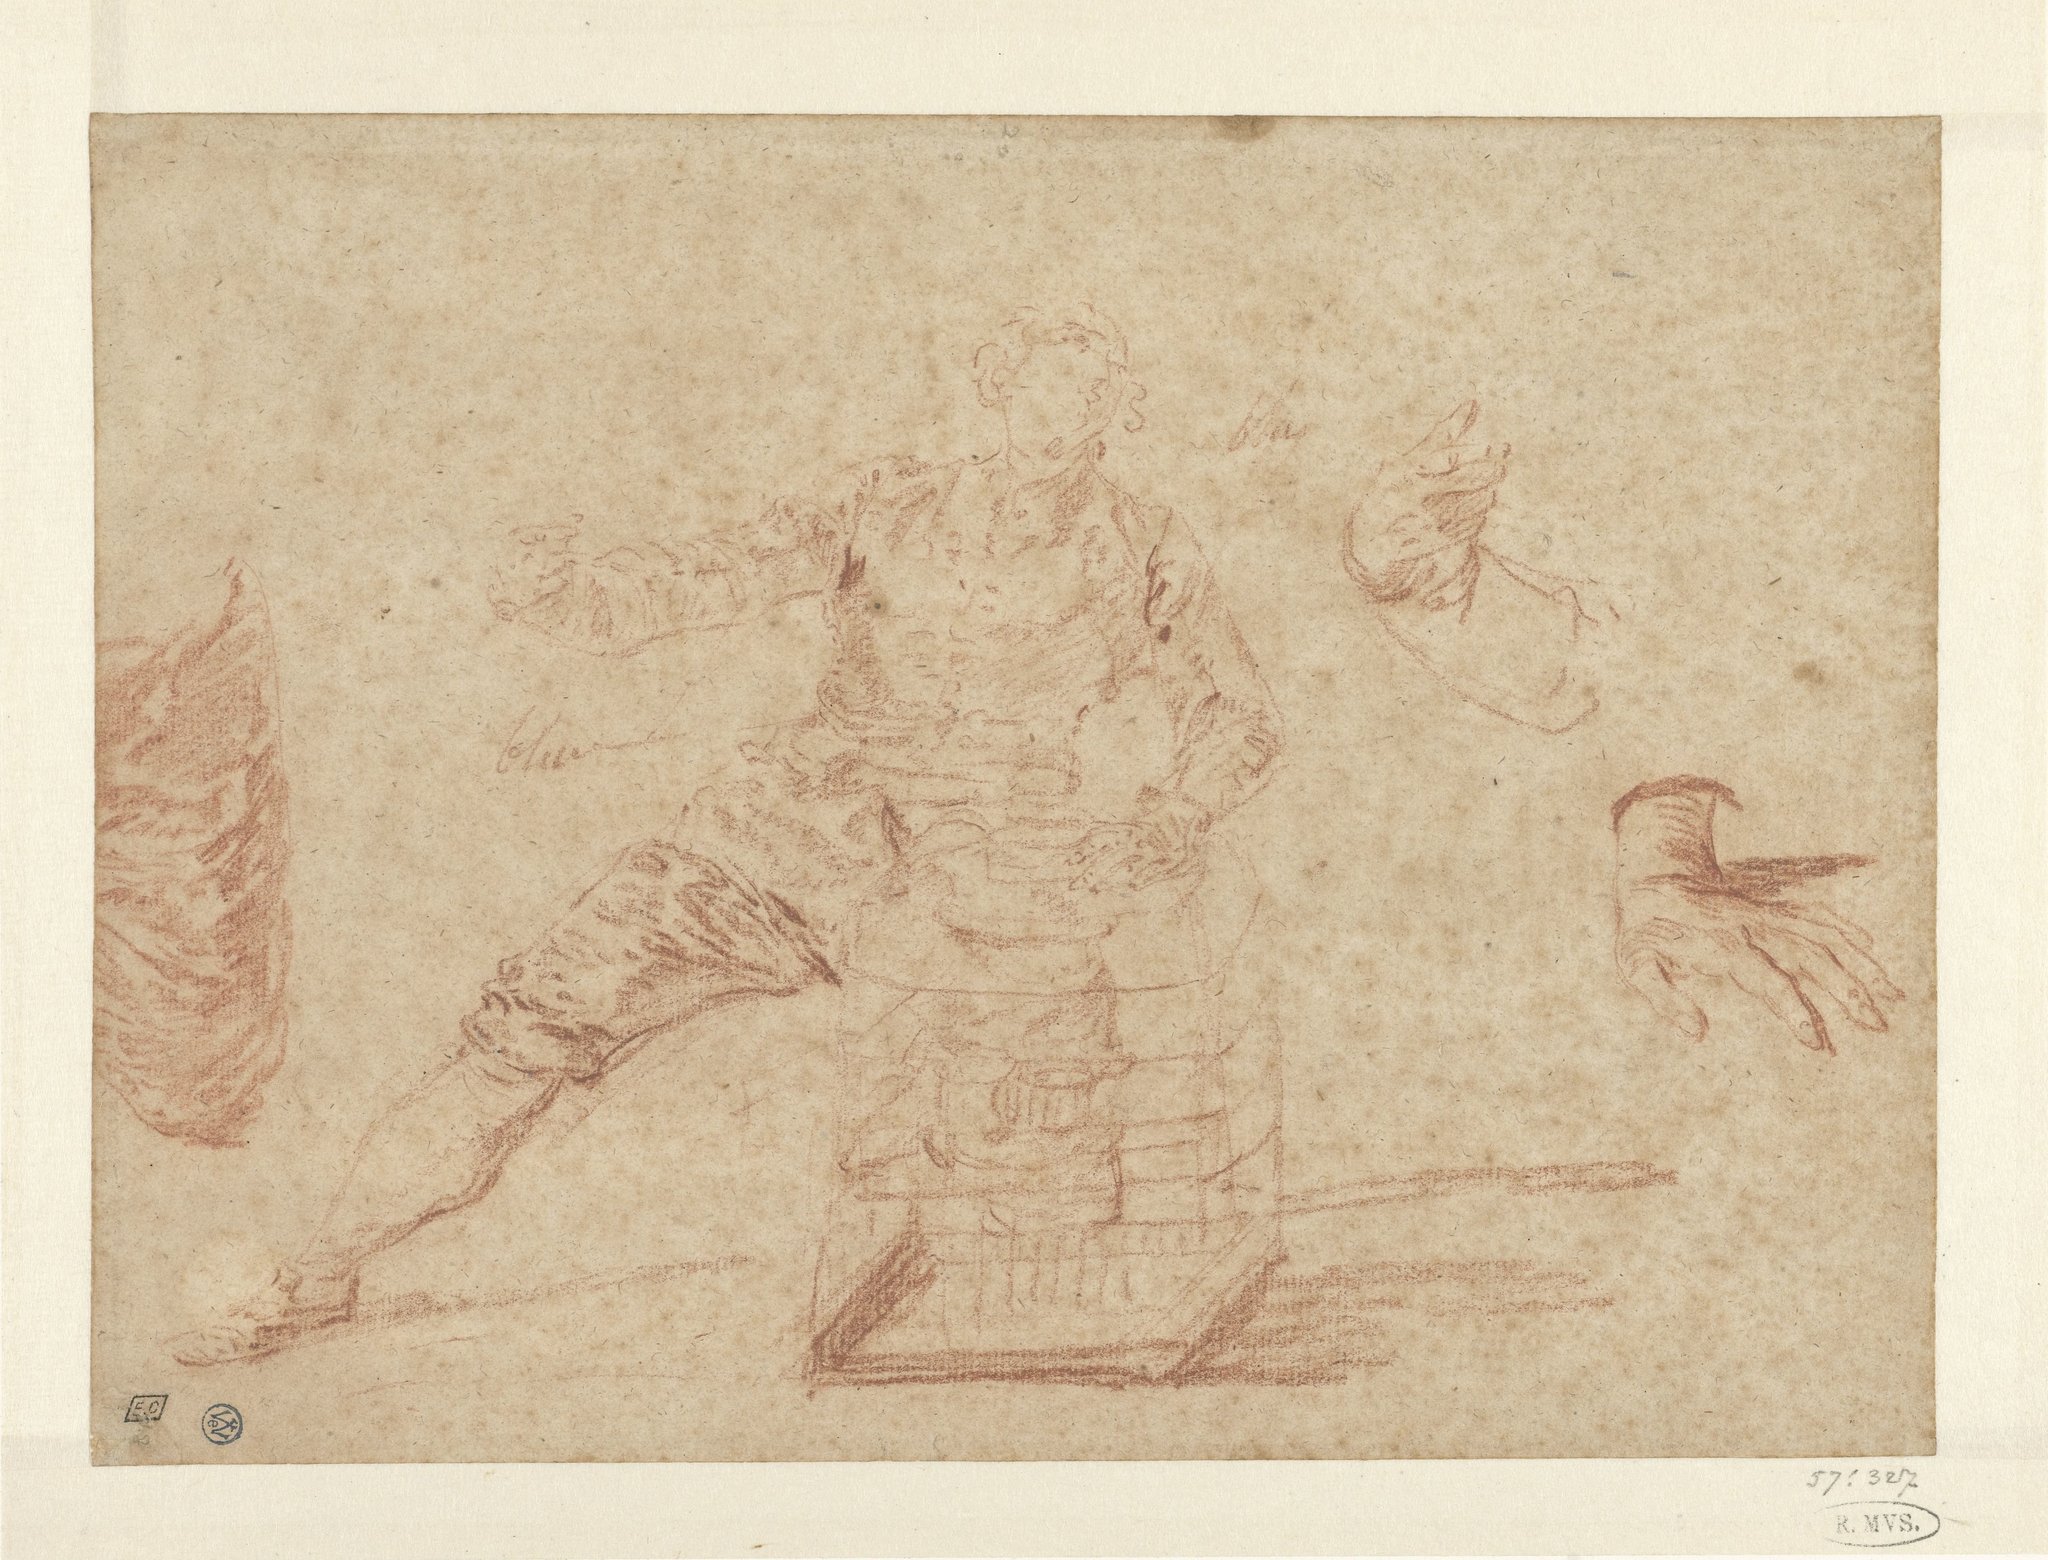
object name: drawing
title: Schetsen van een man, twee handen en een stuk draperie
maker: nicolas lancret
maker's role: draughtsman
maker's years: 1690-1745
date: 1700-1745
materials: chalk, paper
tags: bird in a cage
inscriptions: inscription, recto, red chalk: ‘''bleu'' (tweemaal)’, collector's mark, recto, lower left: Lugt 837, collector's mark, recto, lower left: Lugt 911, collector's mark, recto, on the mount, lower right: Lugt 2228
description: Schetsblad met een zittende man naast een vogelkooi, twee handen los er naast, verder een stuk draperie.